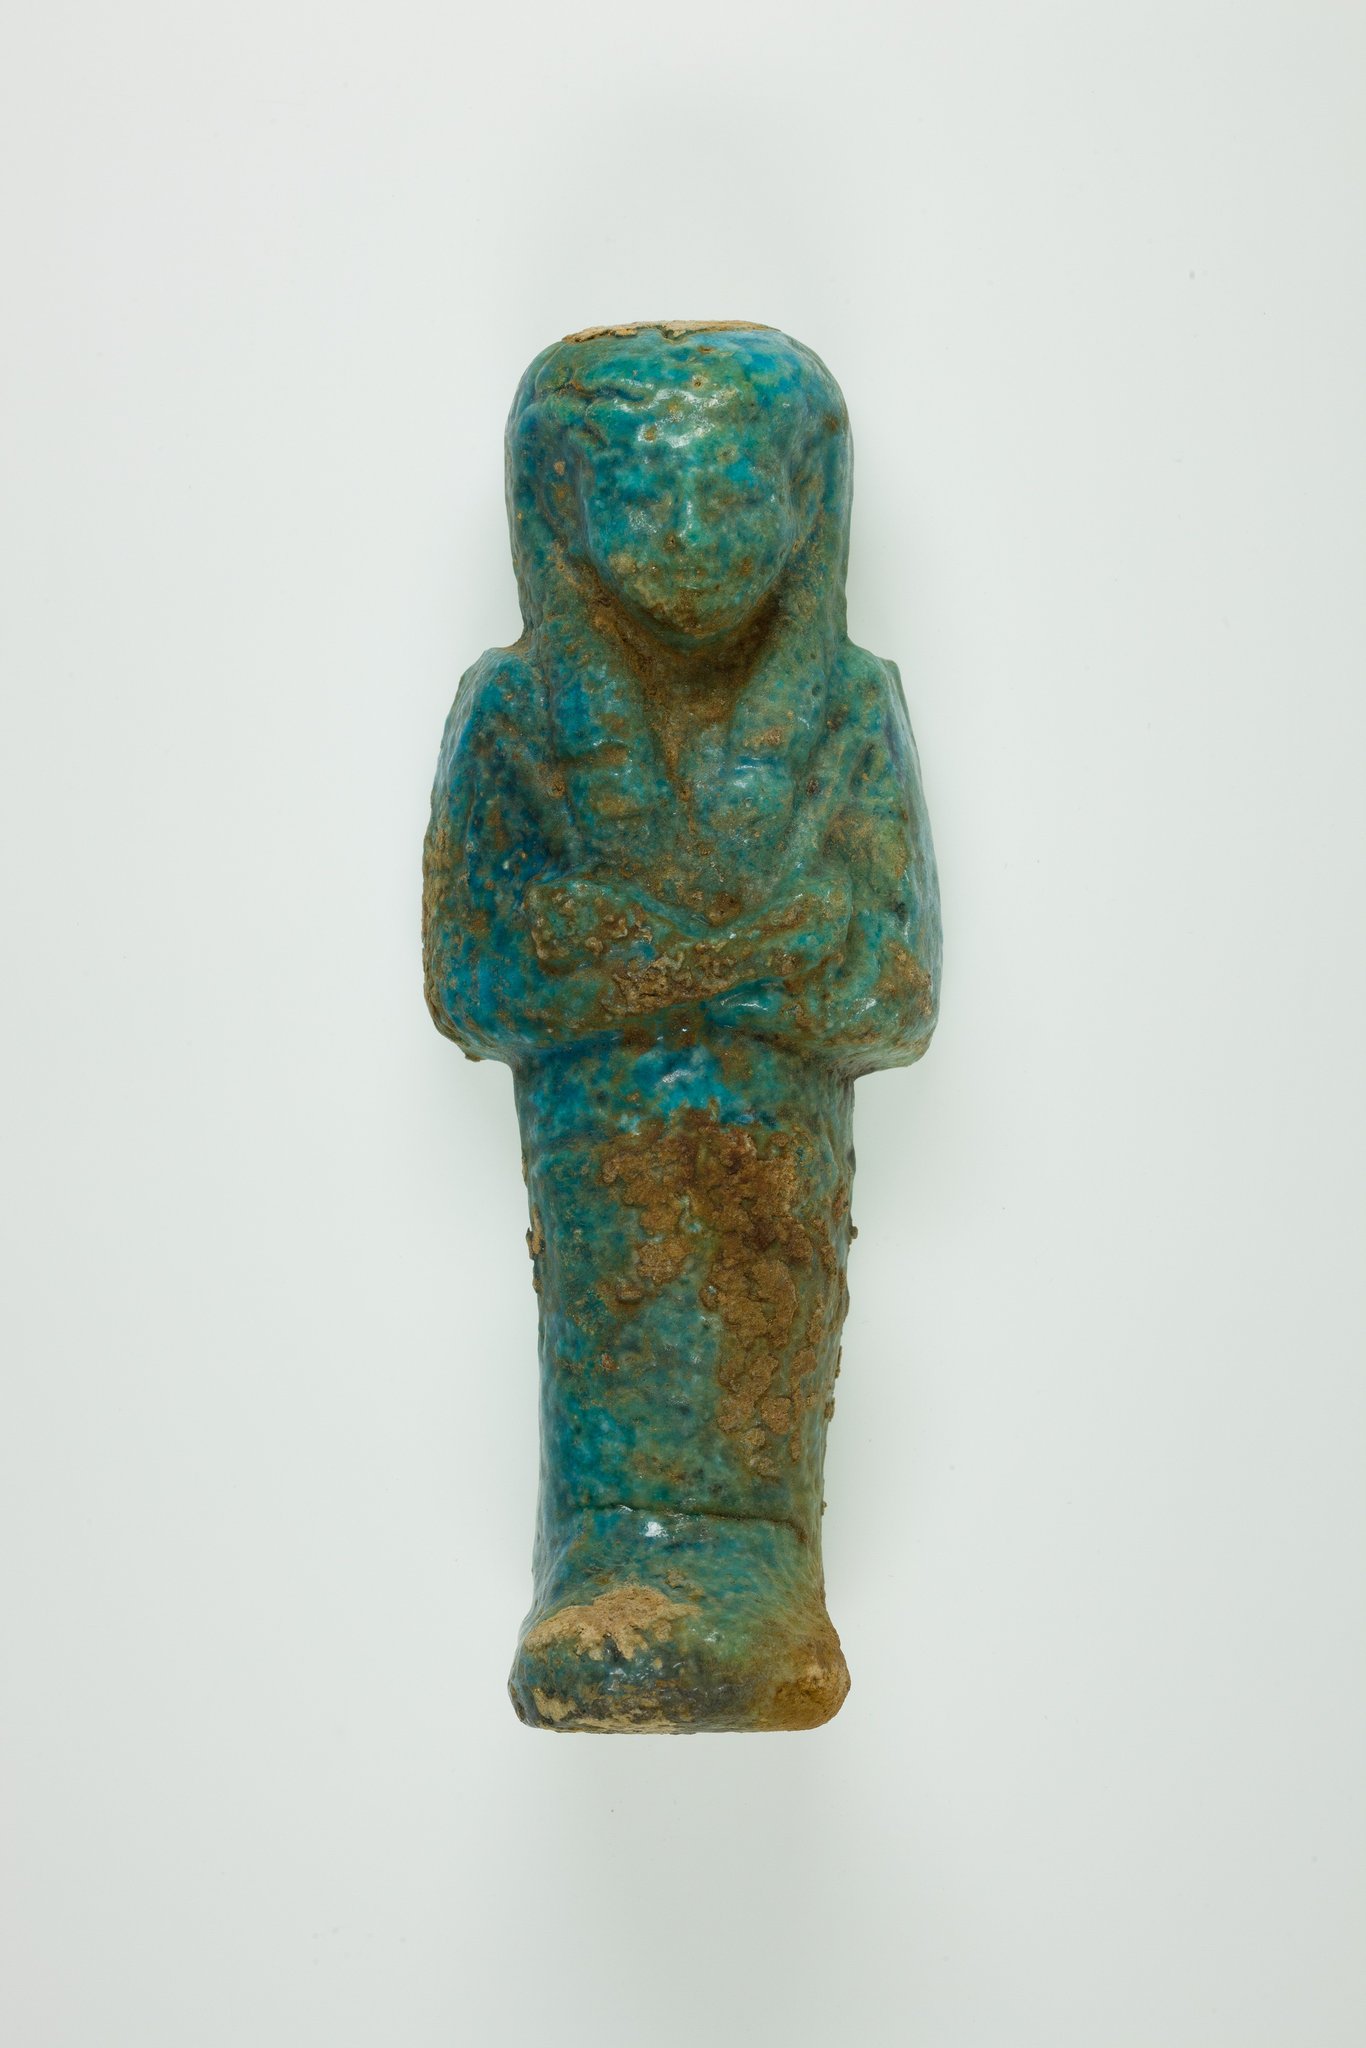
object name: worker shabti, henettawy c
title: Worker Shabti of Henettawy (C), Daughter of Isetemkheb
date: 990-970 BCE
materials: faience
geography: egypt